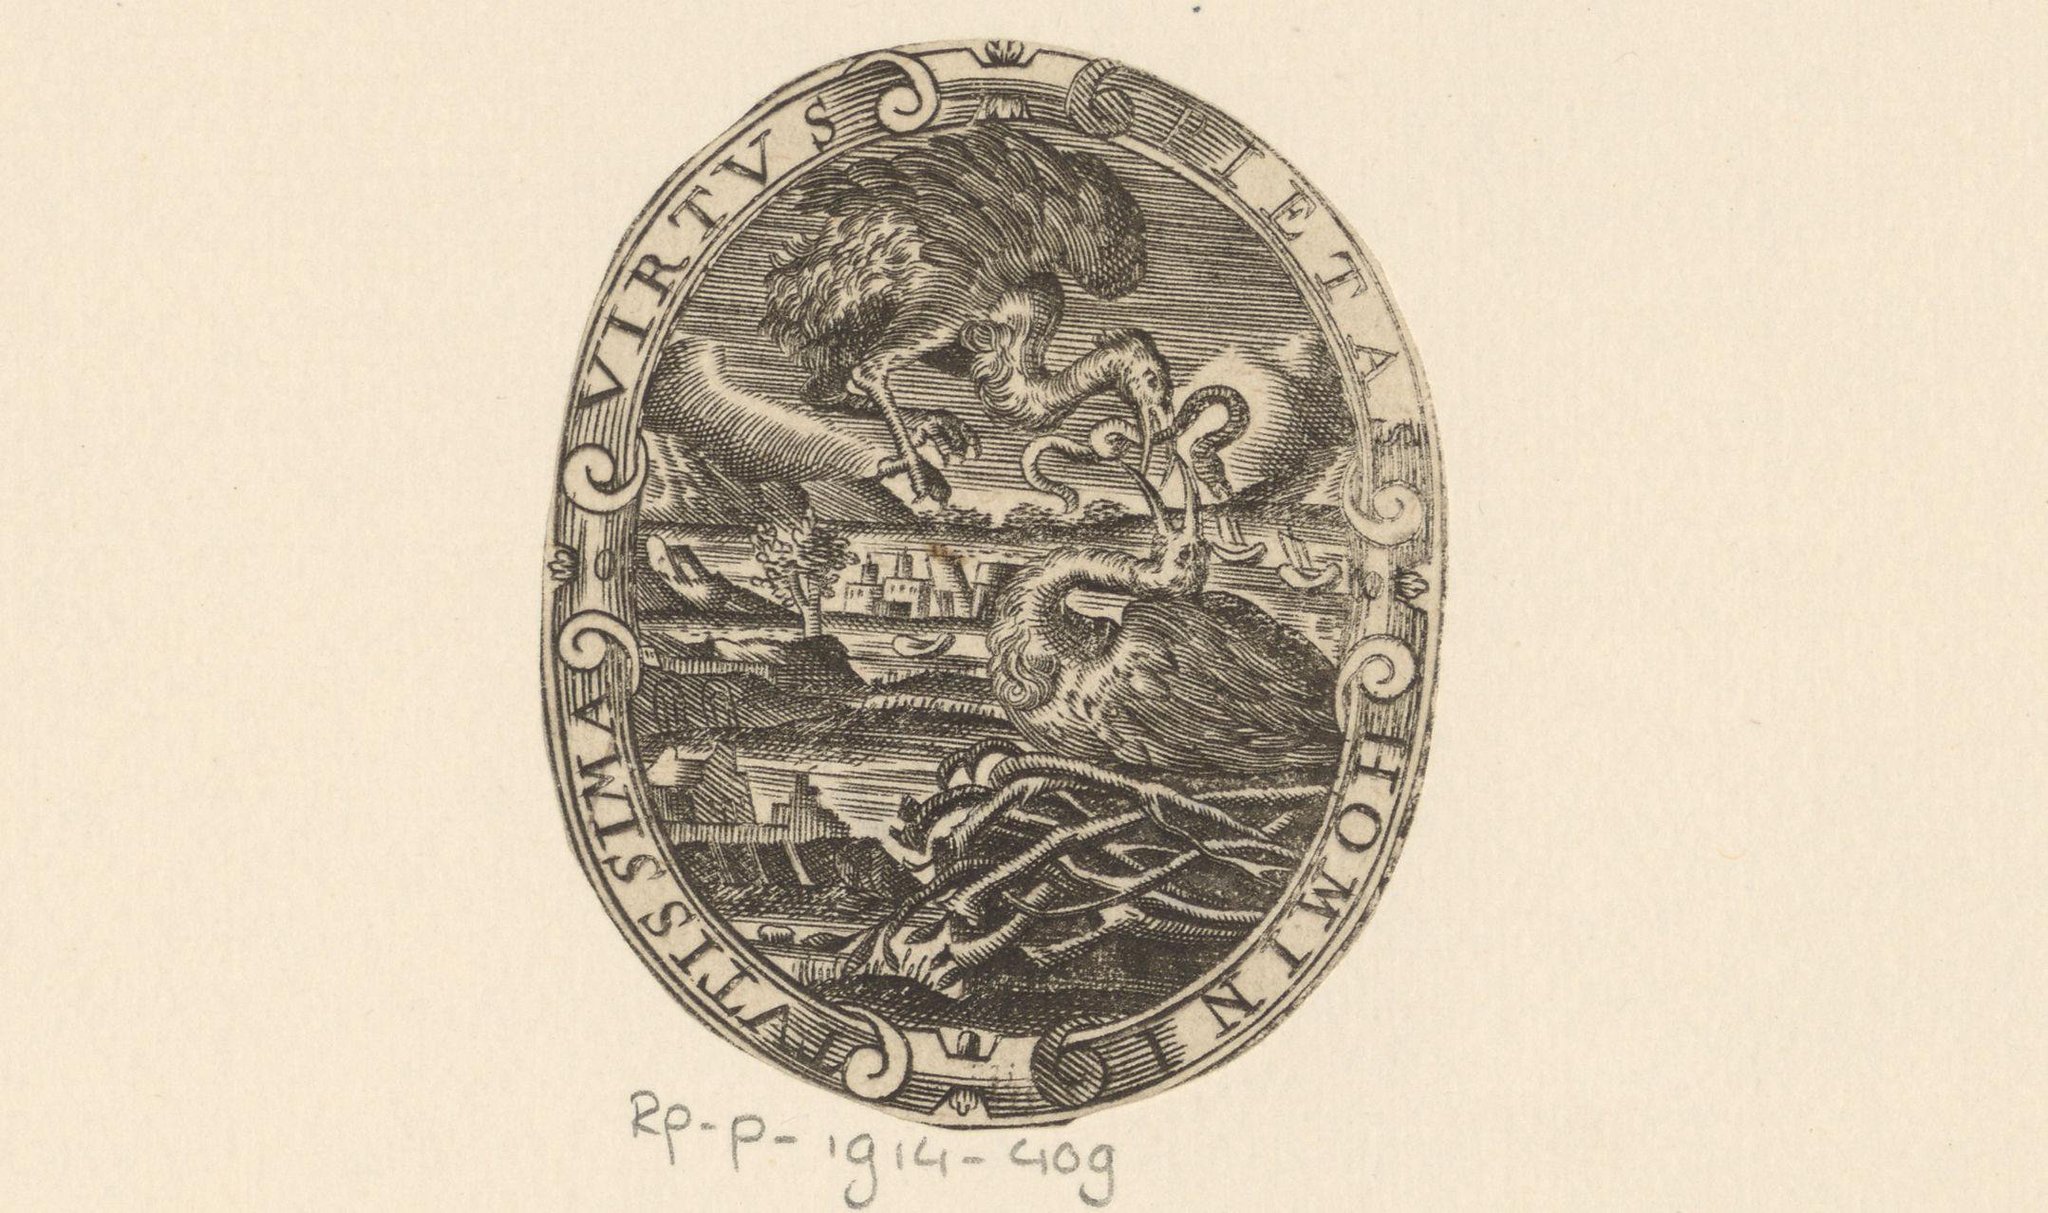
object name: bookplate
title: Pietas homini tutissima virtus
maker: Anonymous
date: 1669-1759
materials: paper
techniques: engraving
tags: birds, animals (+ feeding and care of young)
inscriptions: collector's mark: Lugt 2233, collector's mark: Lugt 2760